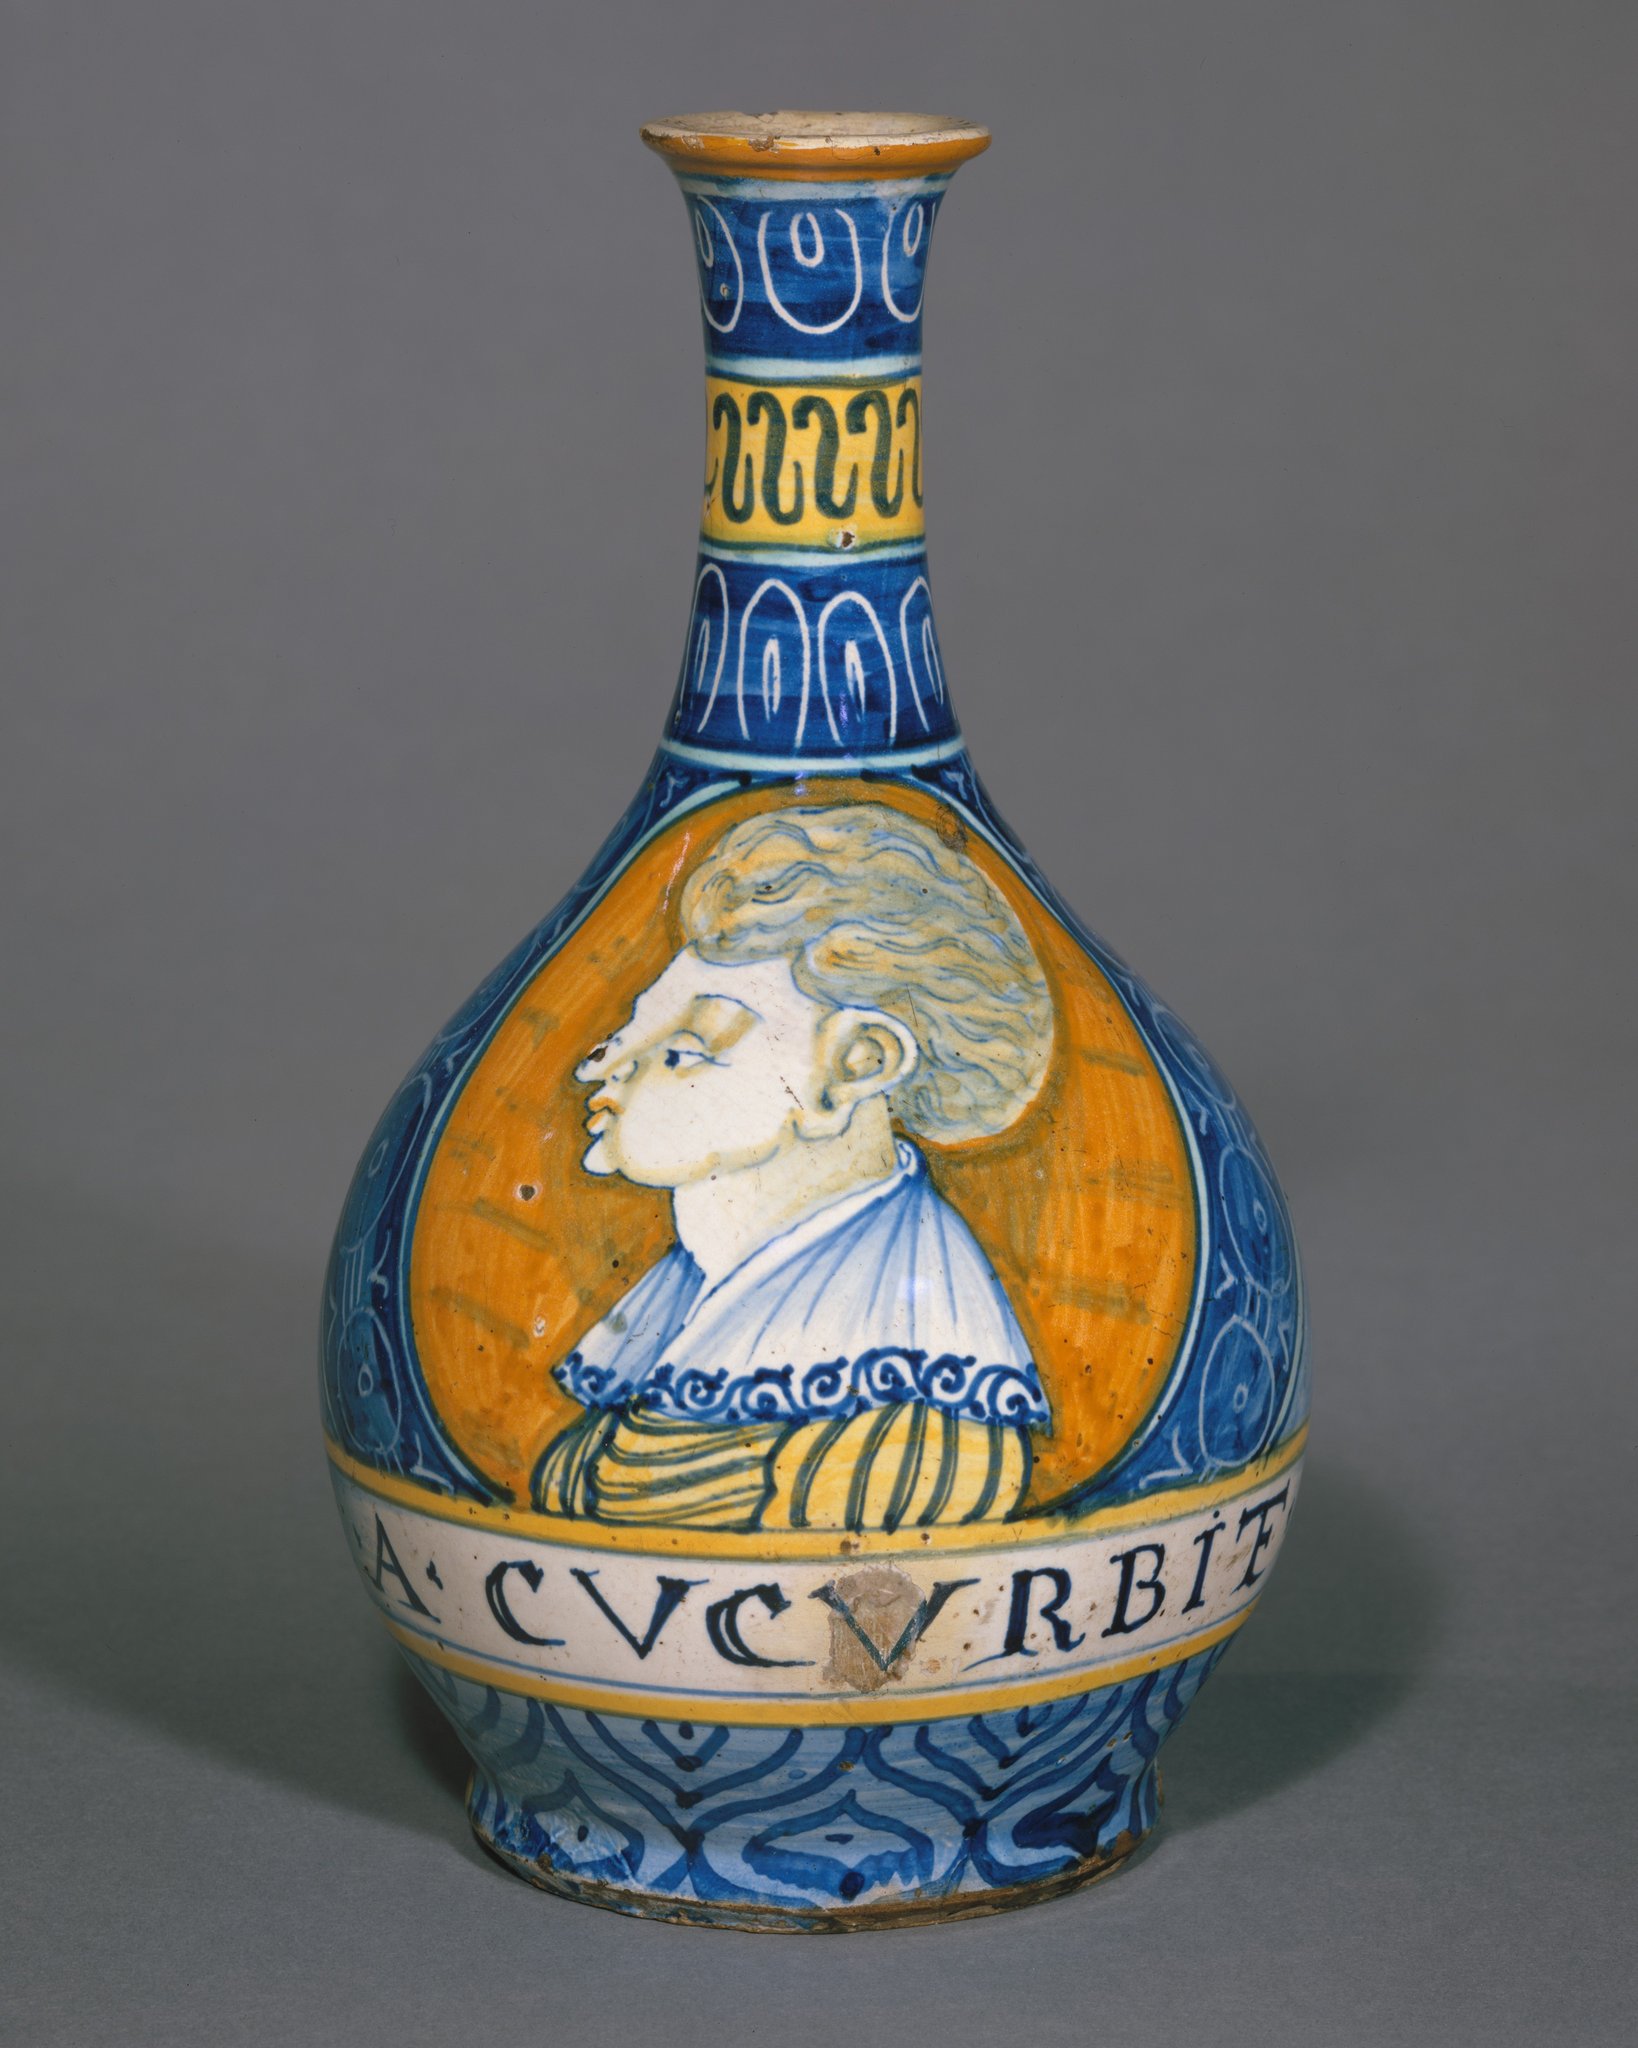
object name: apothecary bottle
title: Apothecary bottle (fiasca da farmacia)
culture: italian, castelli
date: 1530-1540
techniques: maiolica, glazing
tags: men,profiles